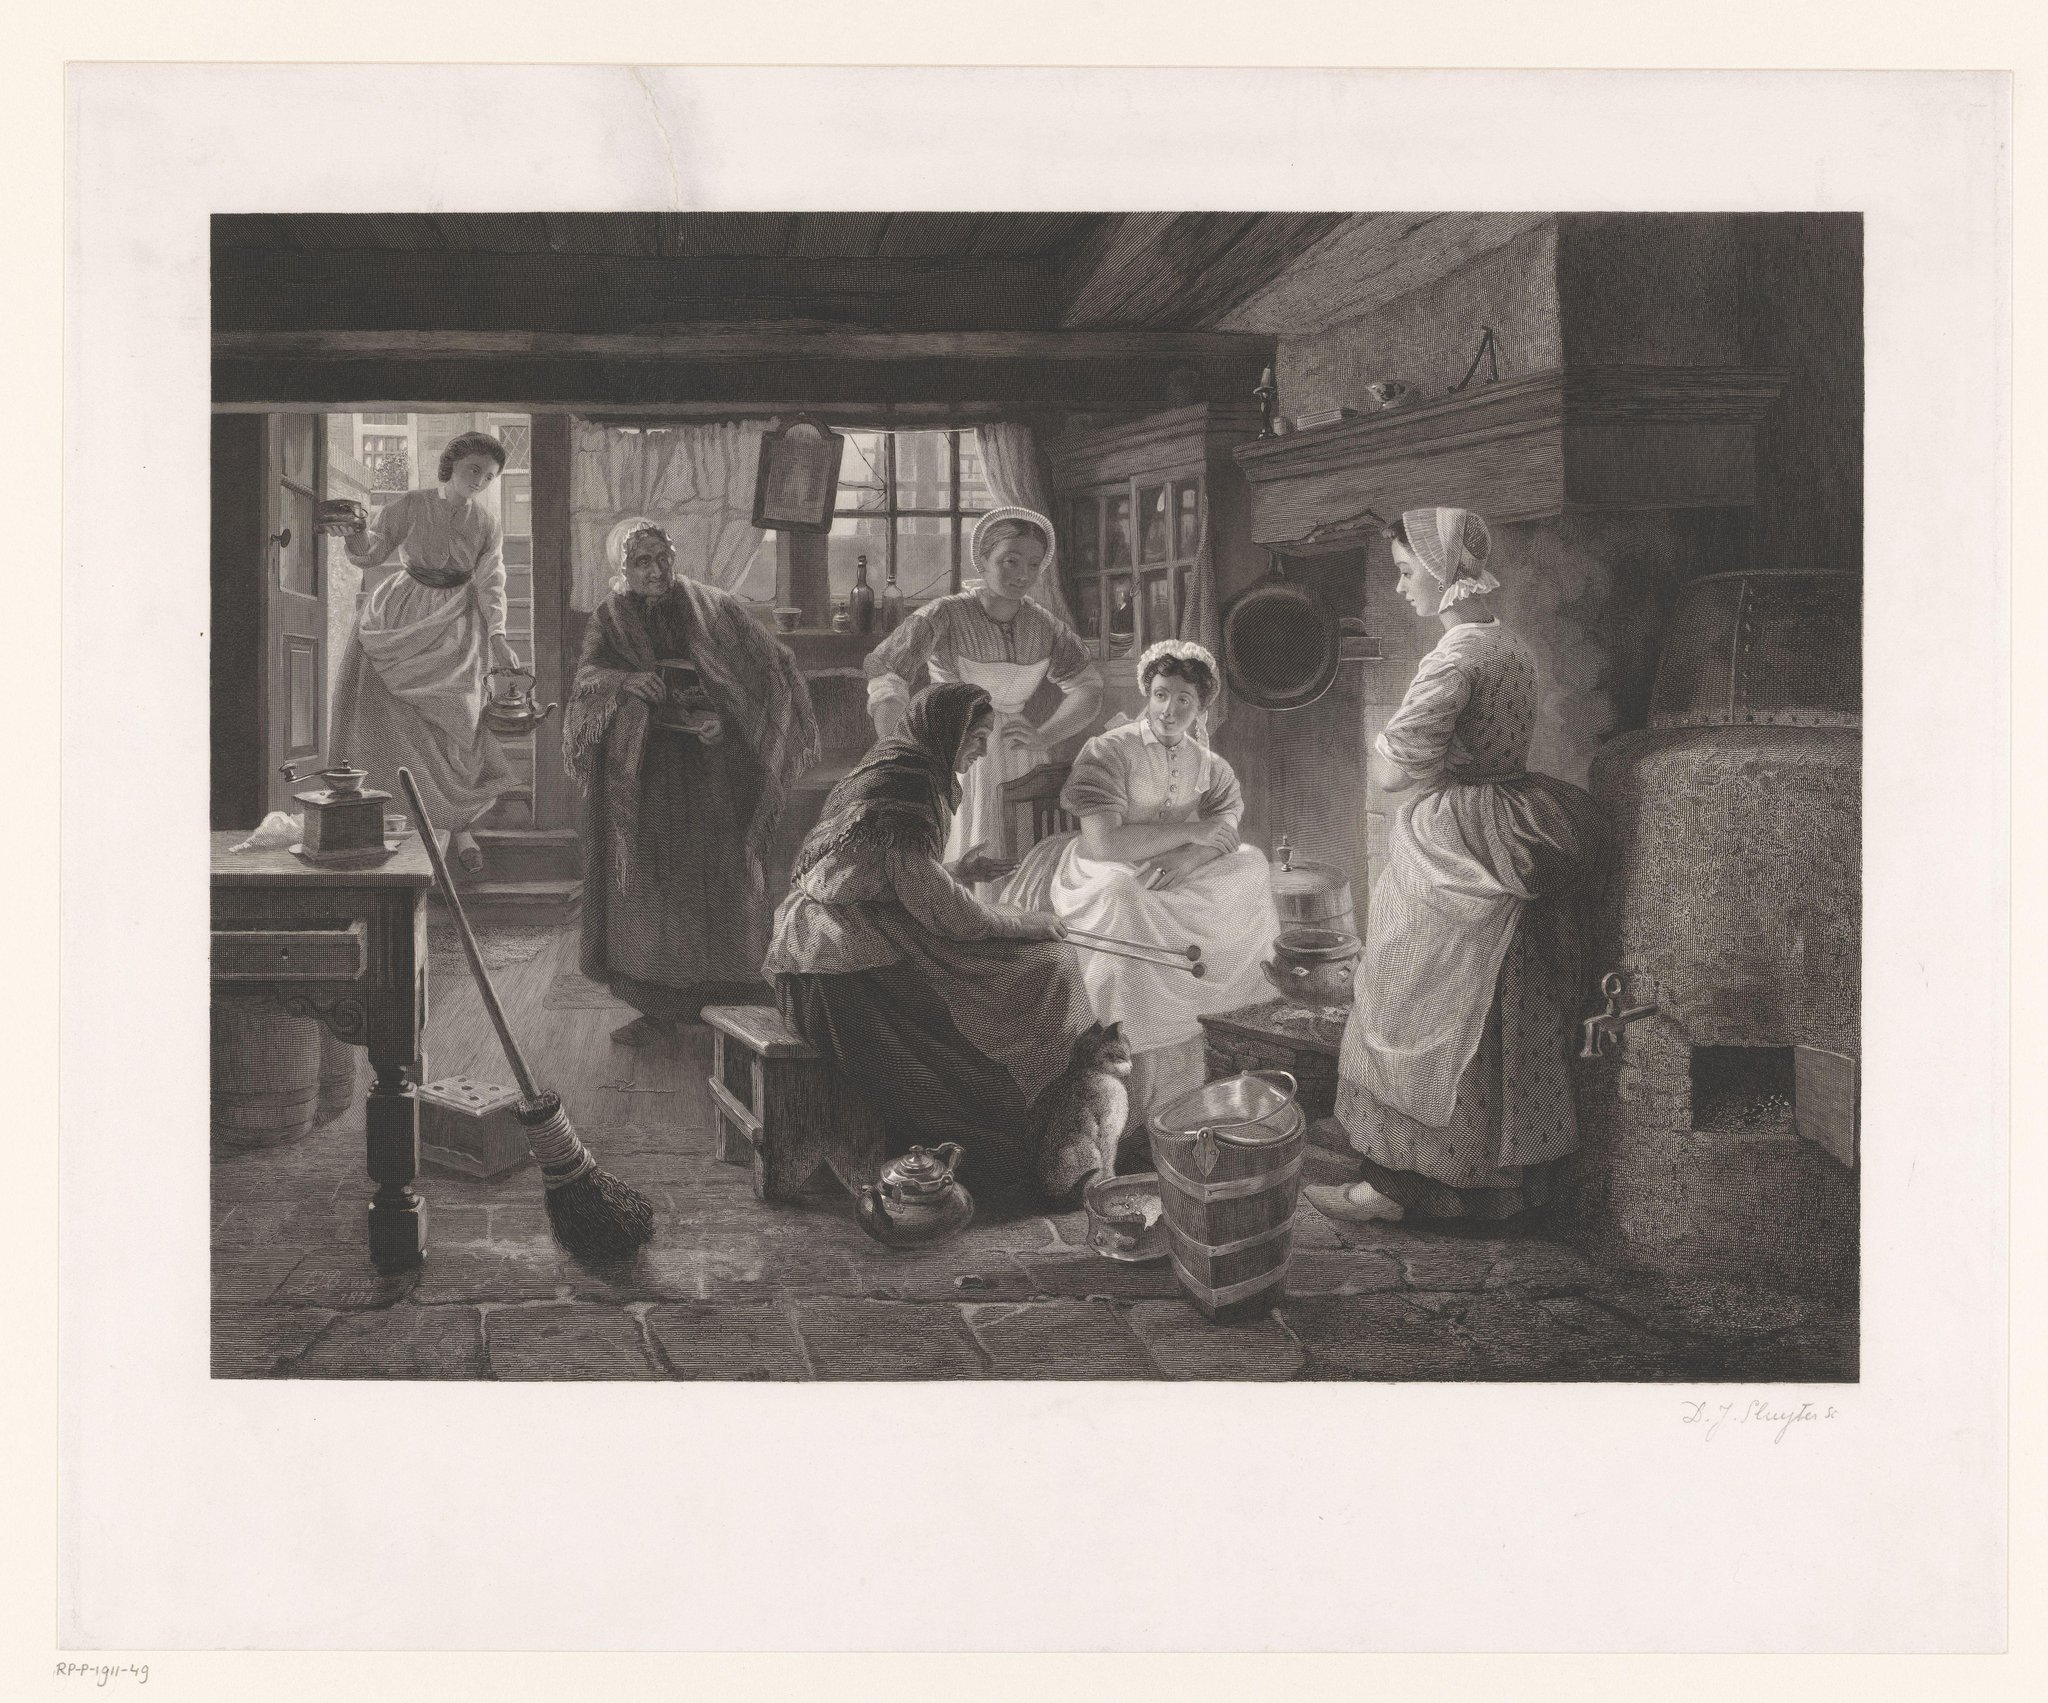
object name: print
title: Water- en vuurkelder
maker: dirk jurriaan sluyter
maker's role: draughtsman, print maker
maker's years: 1811-1886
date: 1872-1886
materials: paper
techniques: engraving, etching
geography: amsterdam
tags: handmill, hot-water bottle, charcoal burning, charcoal burner, wood collier, buying and selling, basement, cellar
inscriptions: collector's mark: Lugt 2228, inscription: ‘de wed. Dikkers Sluyters.’, inscription: ‘D.J. Sluyter sc.’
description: Een groepje vrouwen zit, met een poes aan hun zij, te keuvelen rondom de haard in een water- en vuurkelder. Op de tafel achter hen staat een koffiemolen. Een oude vrouw komt binnen met een stoofje om kooltjes vuur te kopen. Achter haar loopt een jonge vrouw vanaf de straat het trapje naar de kelder af. Zij draagt een pannetje in de hand en een waterketel om heet water te kopen.